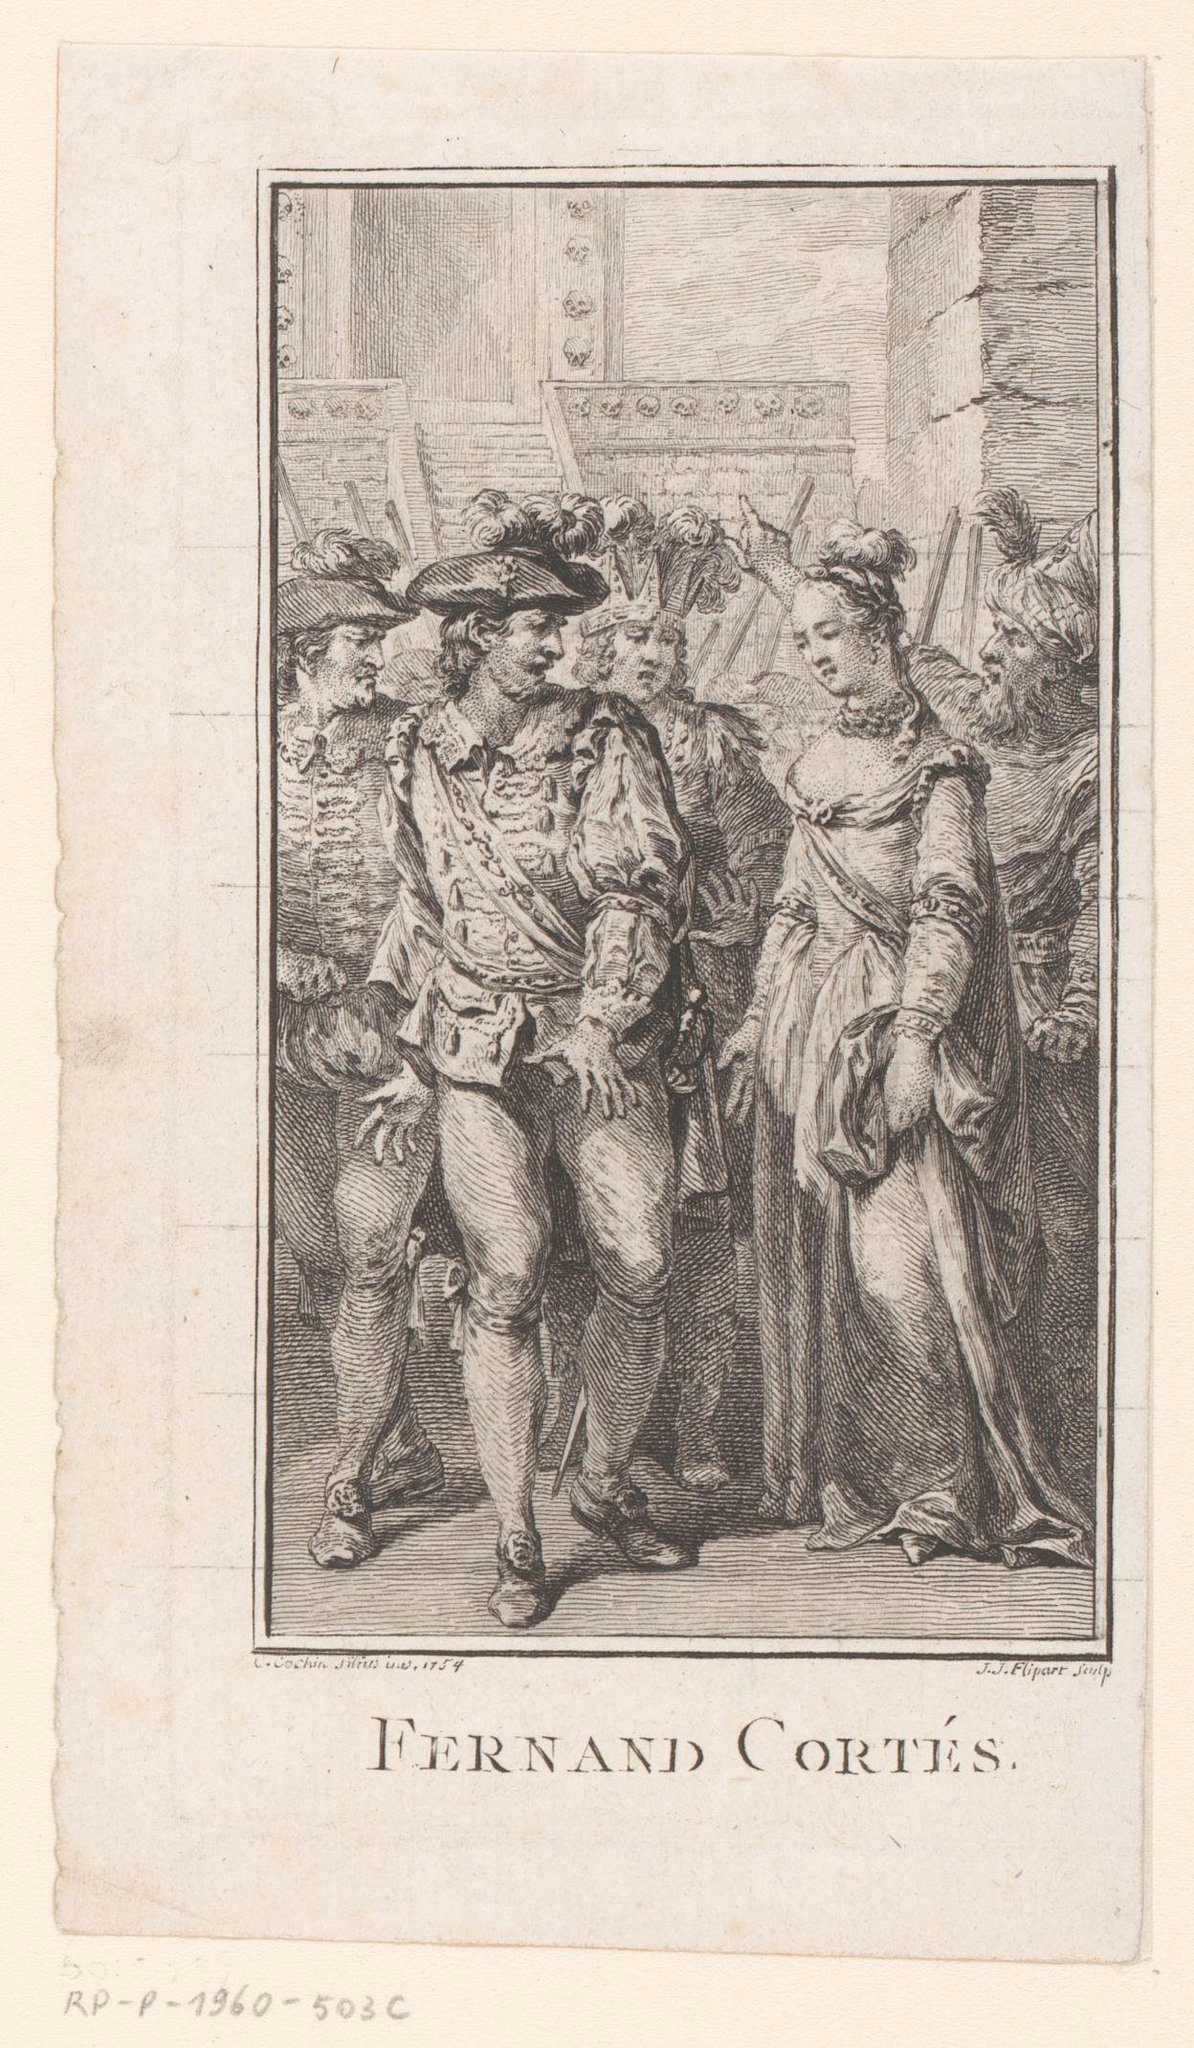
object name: print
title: Vignet met vrouw omringd door mannen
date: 1754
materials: paper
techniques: engraving, etching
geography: france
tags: theatre, theatrical performance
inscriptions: collector's mark: Lugt 2228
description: Prent uit: Piron, Alexis. Oeuvres (...) avec figures en taille douce d'après les dessins de M. Cochin. Parijs: Duchesne, 1758, dl. 3, p. 433.